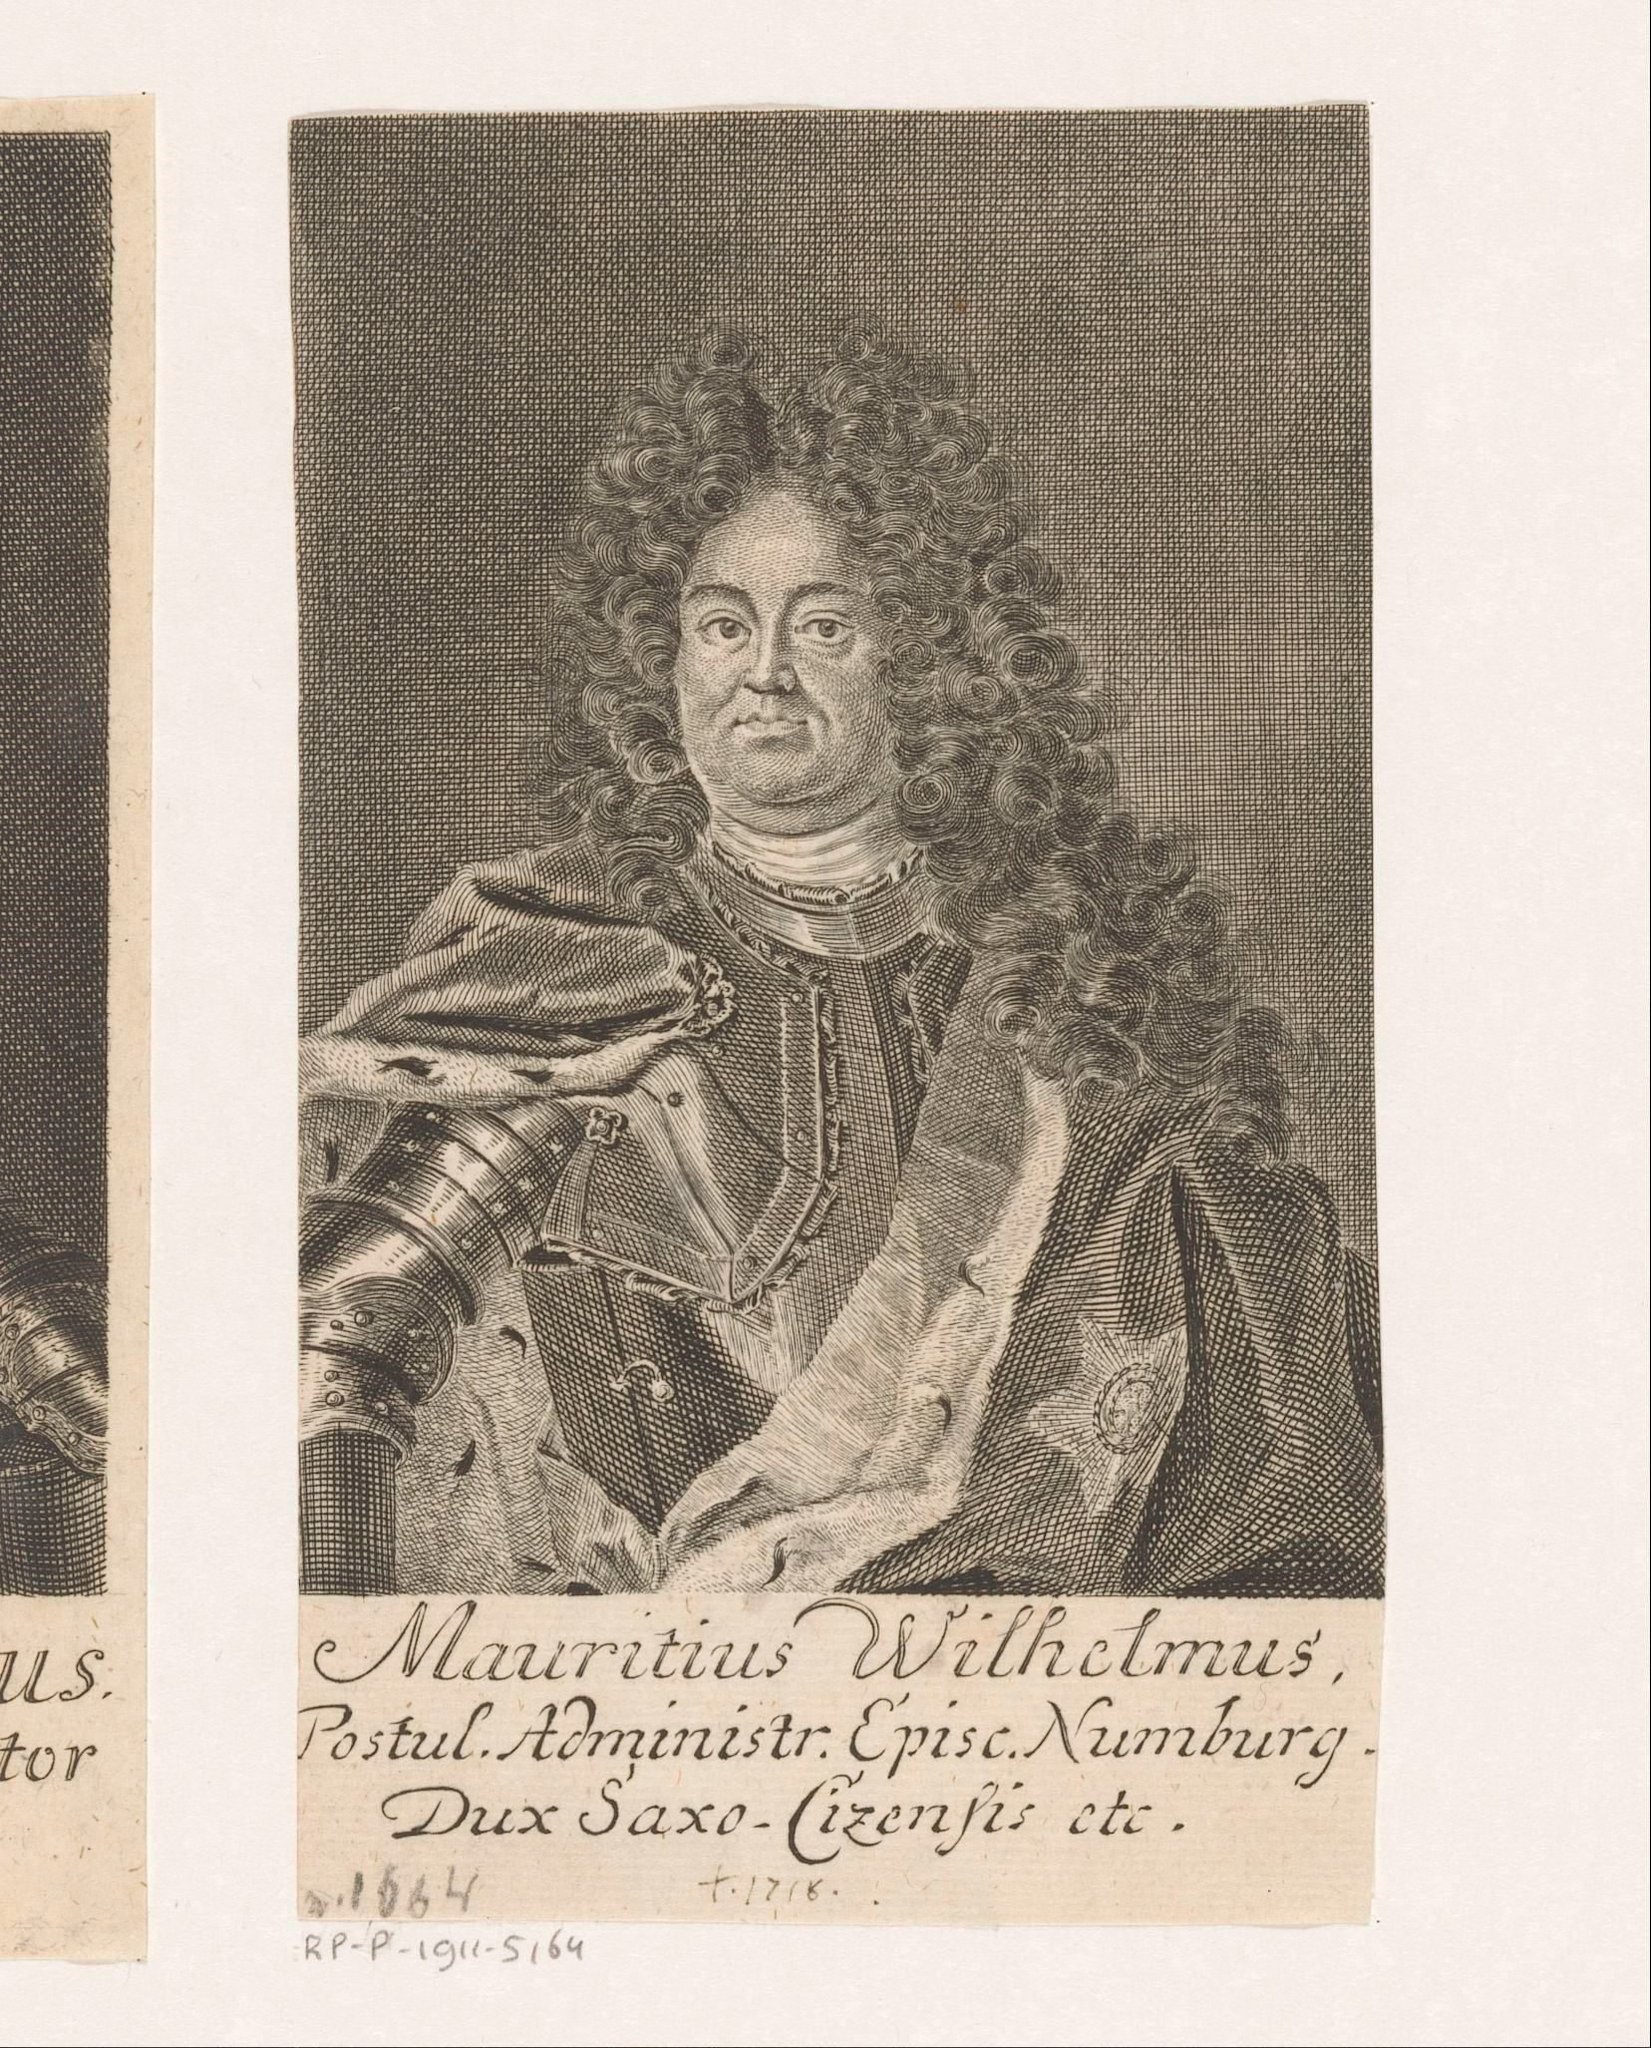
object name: print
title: Portret van Moritz Wilhelm von Sachsen-Zeitz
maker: martin bernigeroth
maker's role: print maker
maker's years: 1670-1733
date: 1713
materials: paper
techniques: engraving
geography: leipzig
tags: knighthood order, armour, historical persons, mantle, gown, dress (symbol of sovereignty)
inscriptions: collector's mark: Lugt 2228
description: Prent ook gebruikt in: Die Europäische Fama, Welche den gegenwärtigen Zustand der vornehmsten Höfe entdecket. dl. 144. Leipzig: Gleditsch, 1713.